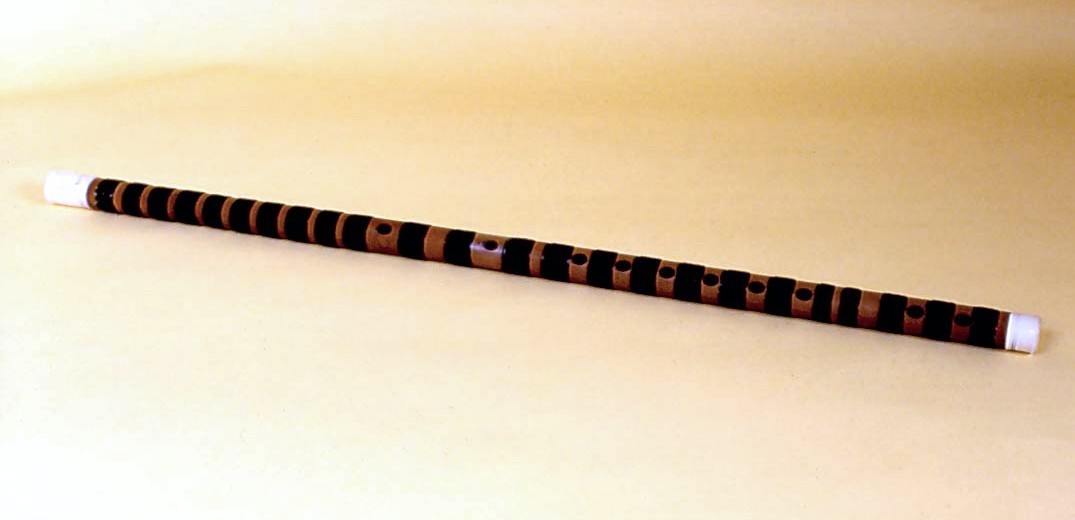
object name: dizi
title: Dizi (笛子 )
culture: chinese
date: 1867-1900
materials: bamboo, ivory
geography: china